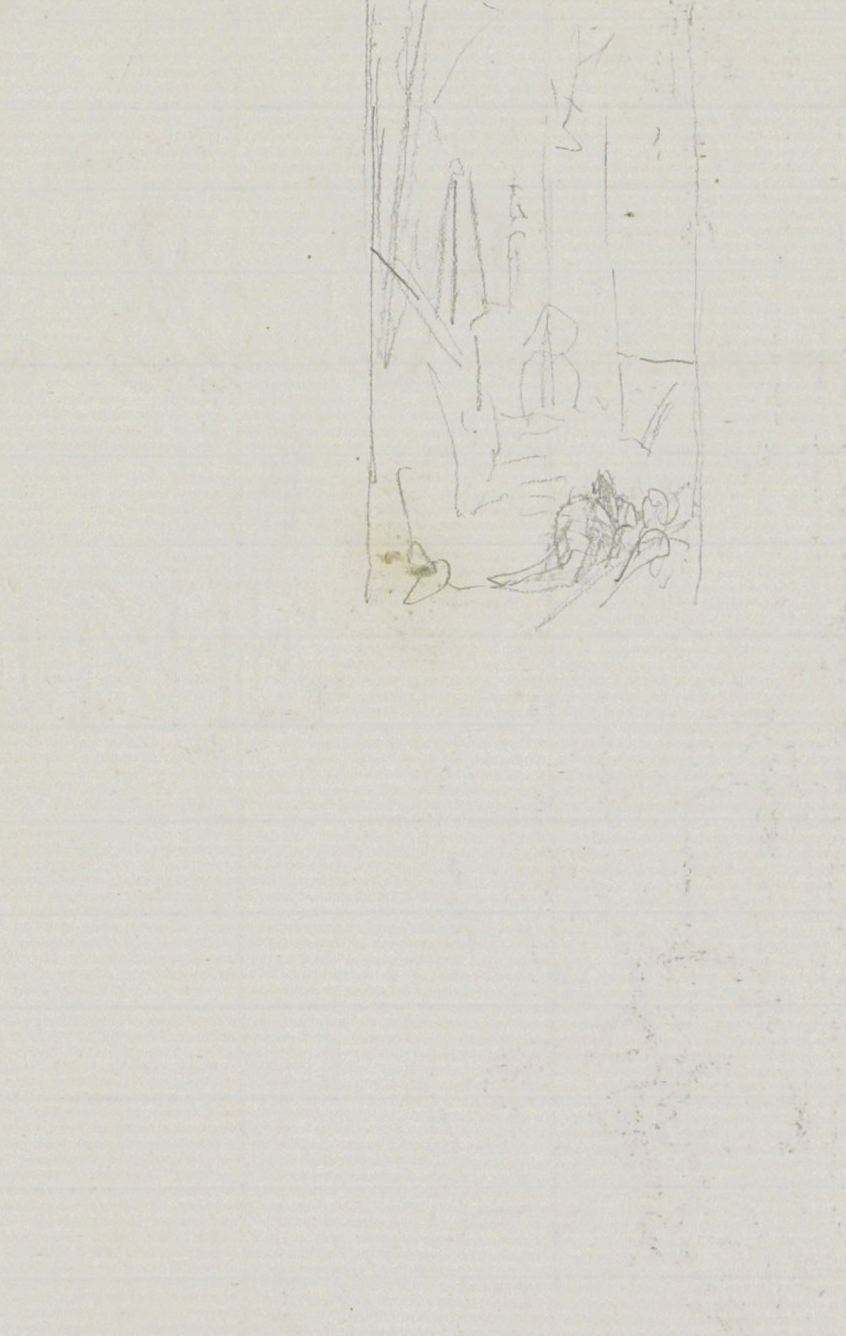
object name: sketchbook leaf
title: Straat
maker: marius bauer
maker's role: draughtsman, print maker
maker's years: 1867-1932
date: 1877-1932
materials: pencil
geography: paris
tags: street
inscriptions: annotation: ‘Parijs’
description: Pagina 136 uit een schetsboek met 68 bladen.